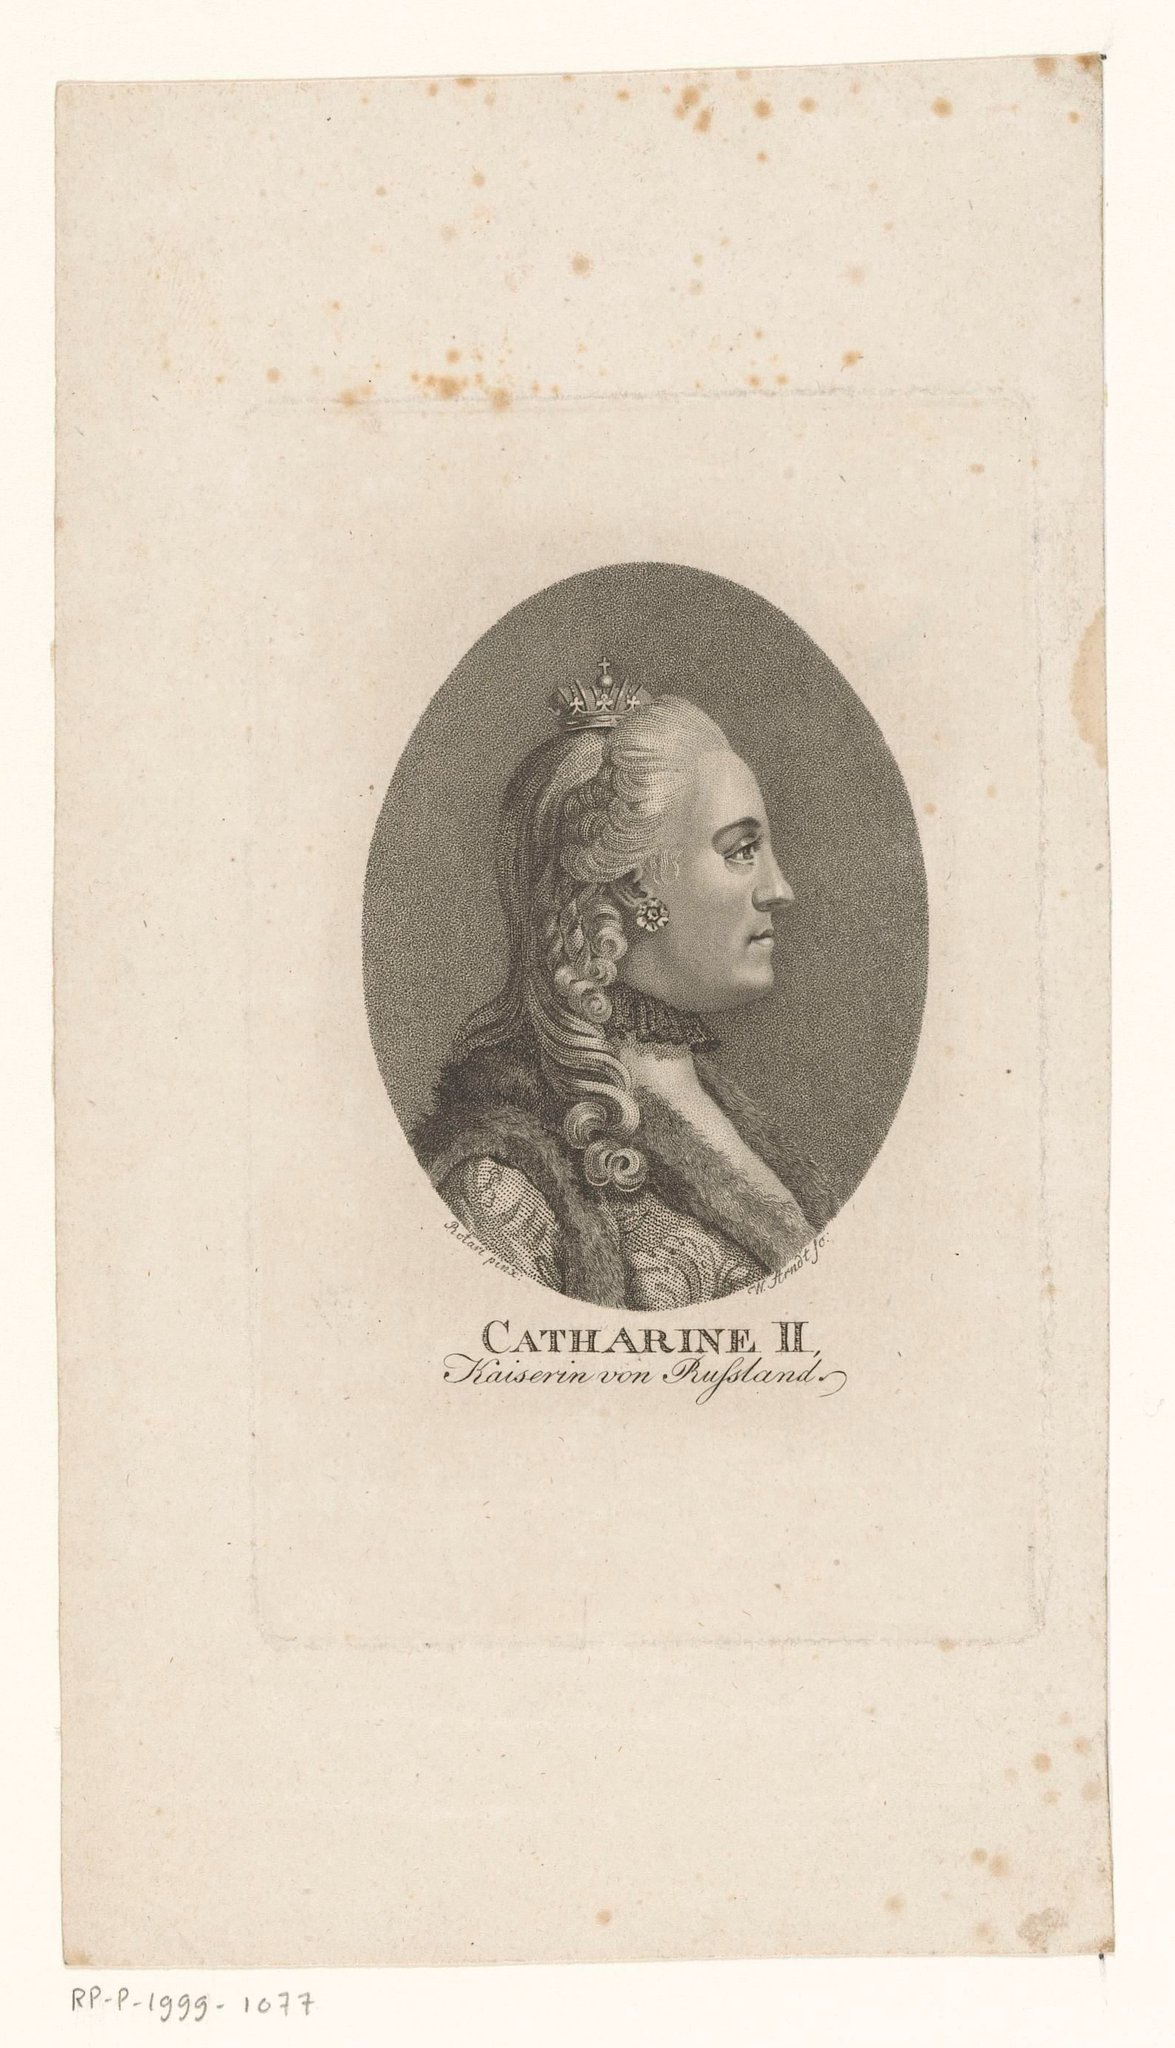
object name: print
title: Portret Catharina II, keizerin van Rusland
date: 1762-1813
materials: paper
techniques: stippling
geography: sint-petersburg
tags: catharina de grote, historical persons - bb - woman, insignia and symbols of sovereignty (crown, diadem, sceptre, orb, seal, standard, cloak, pectoral)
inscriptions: collector's mark: Lugt 2228, collector's mark: Lugt 2760